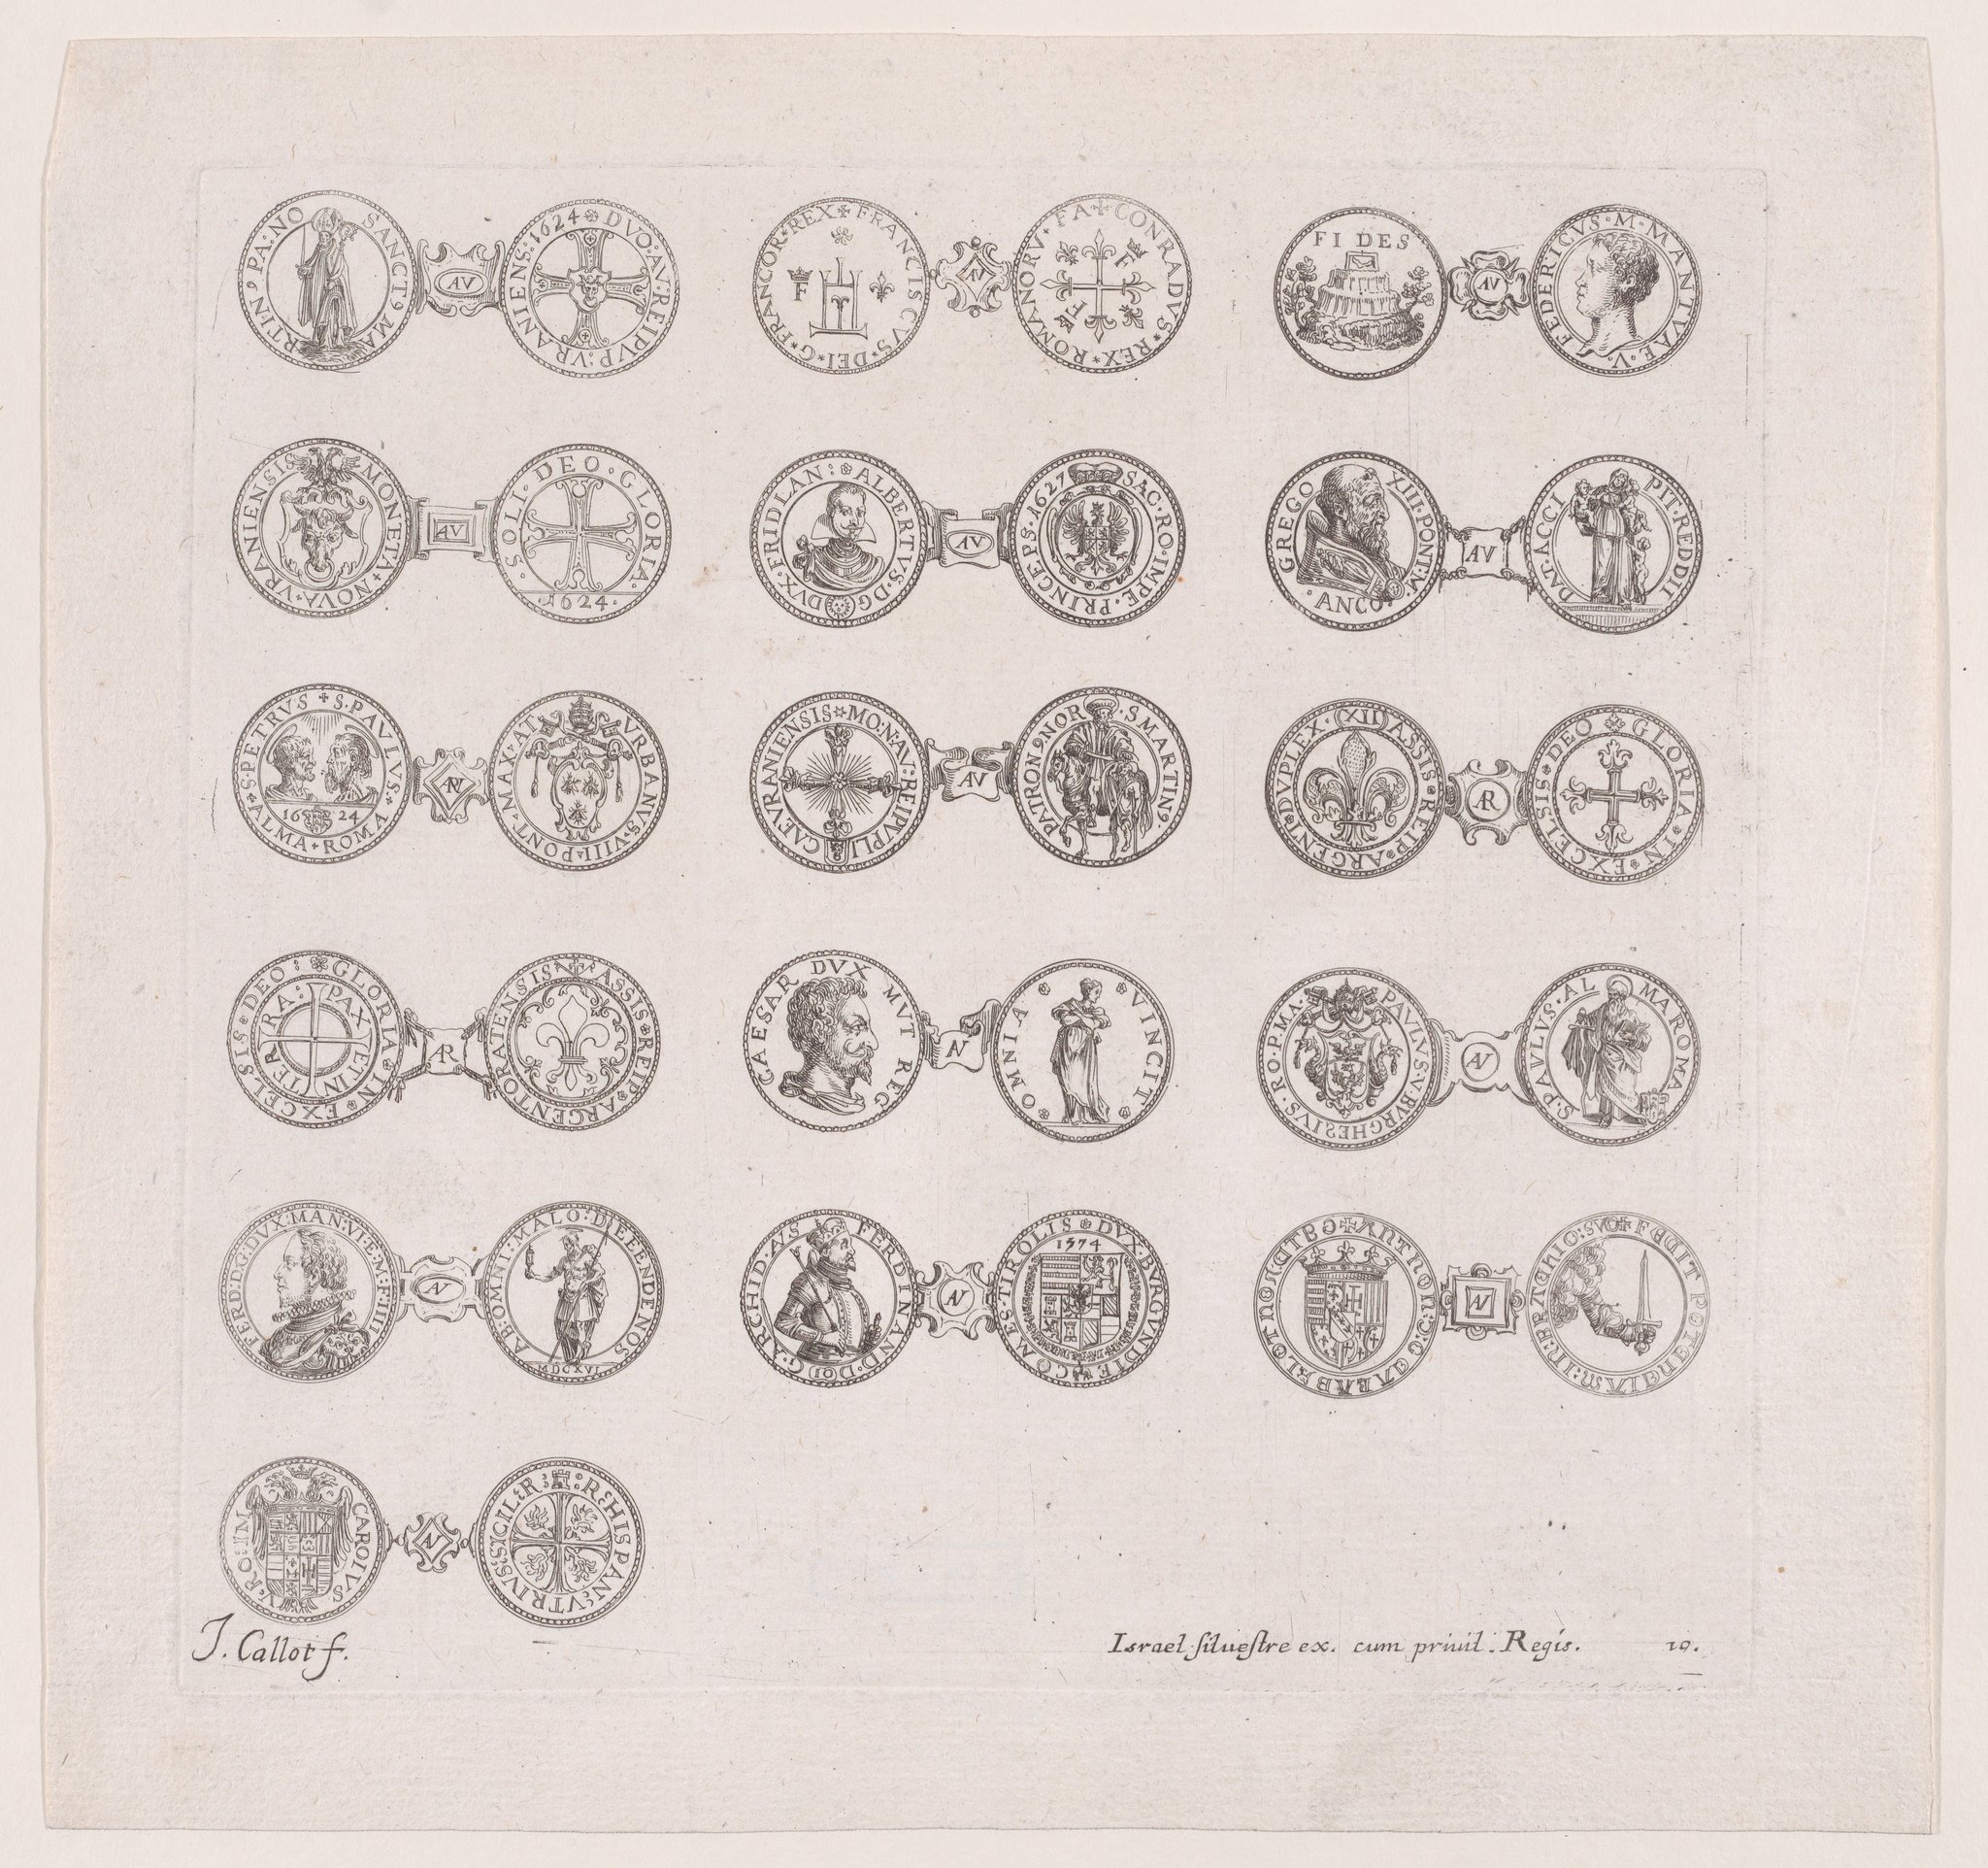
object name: print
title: Plate 10, Featuring 16 Coins Issued by European Princes in the 16th and 17th centuries, from "Les Monnaies" (The Currencies)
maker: jacques callot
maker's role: artist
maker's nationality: french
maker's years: 1592-1635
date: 1630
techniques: etching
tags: coins